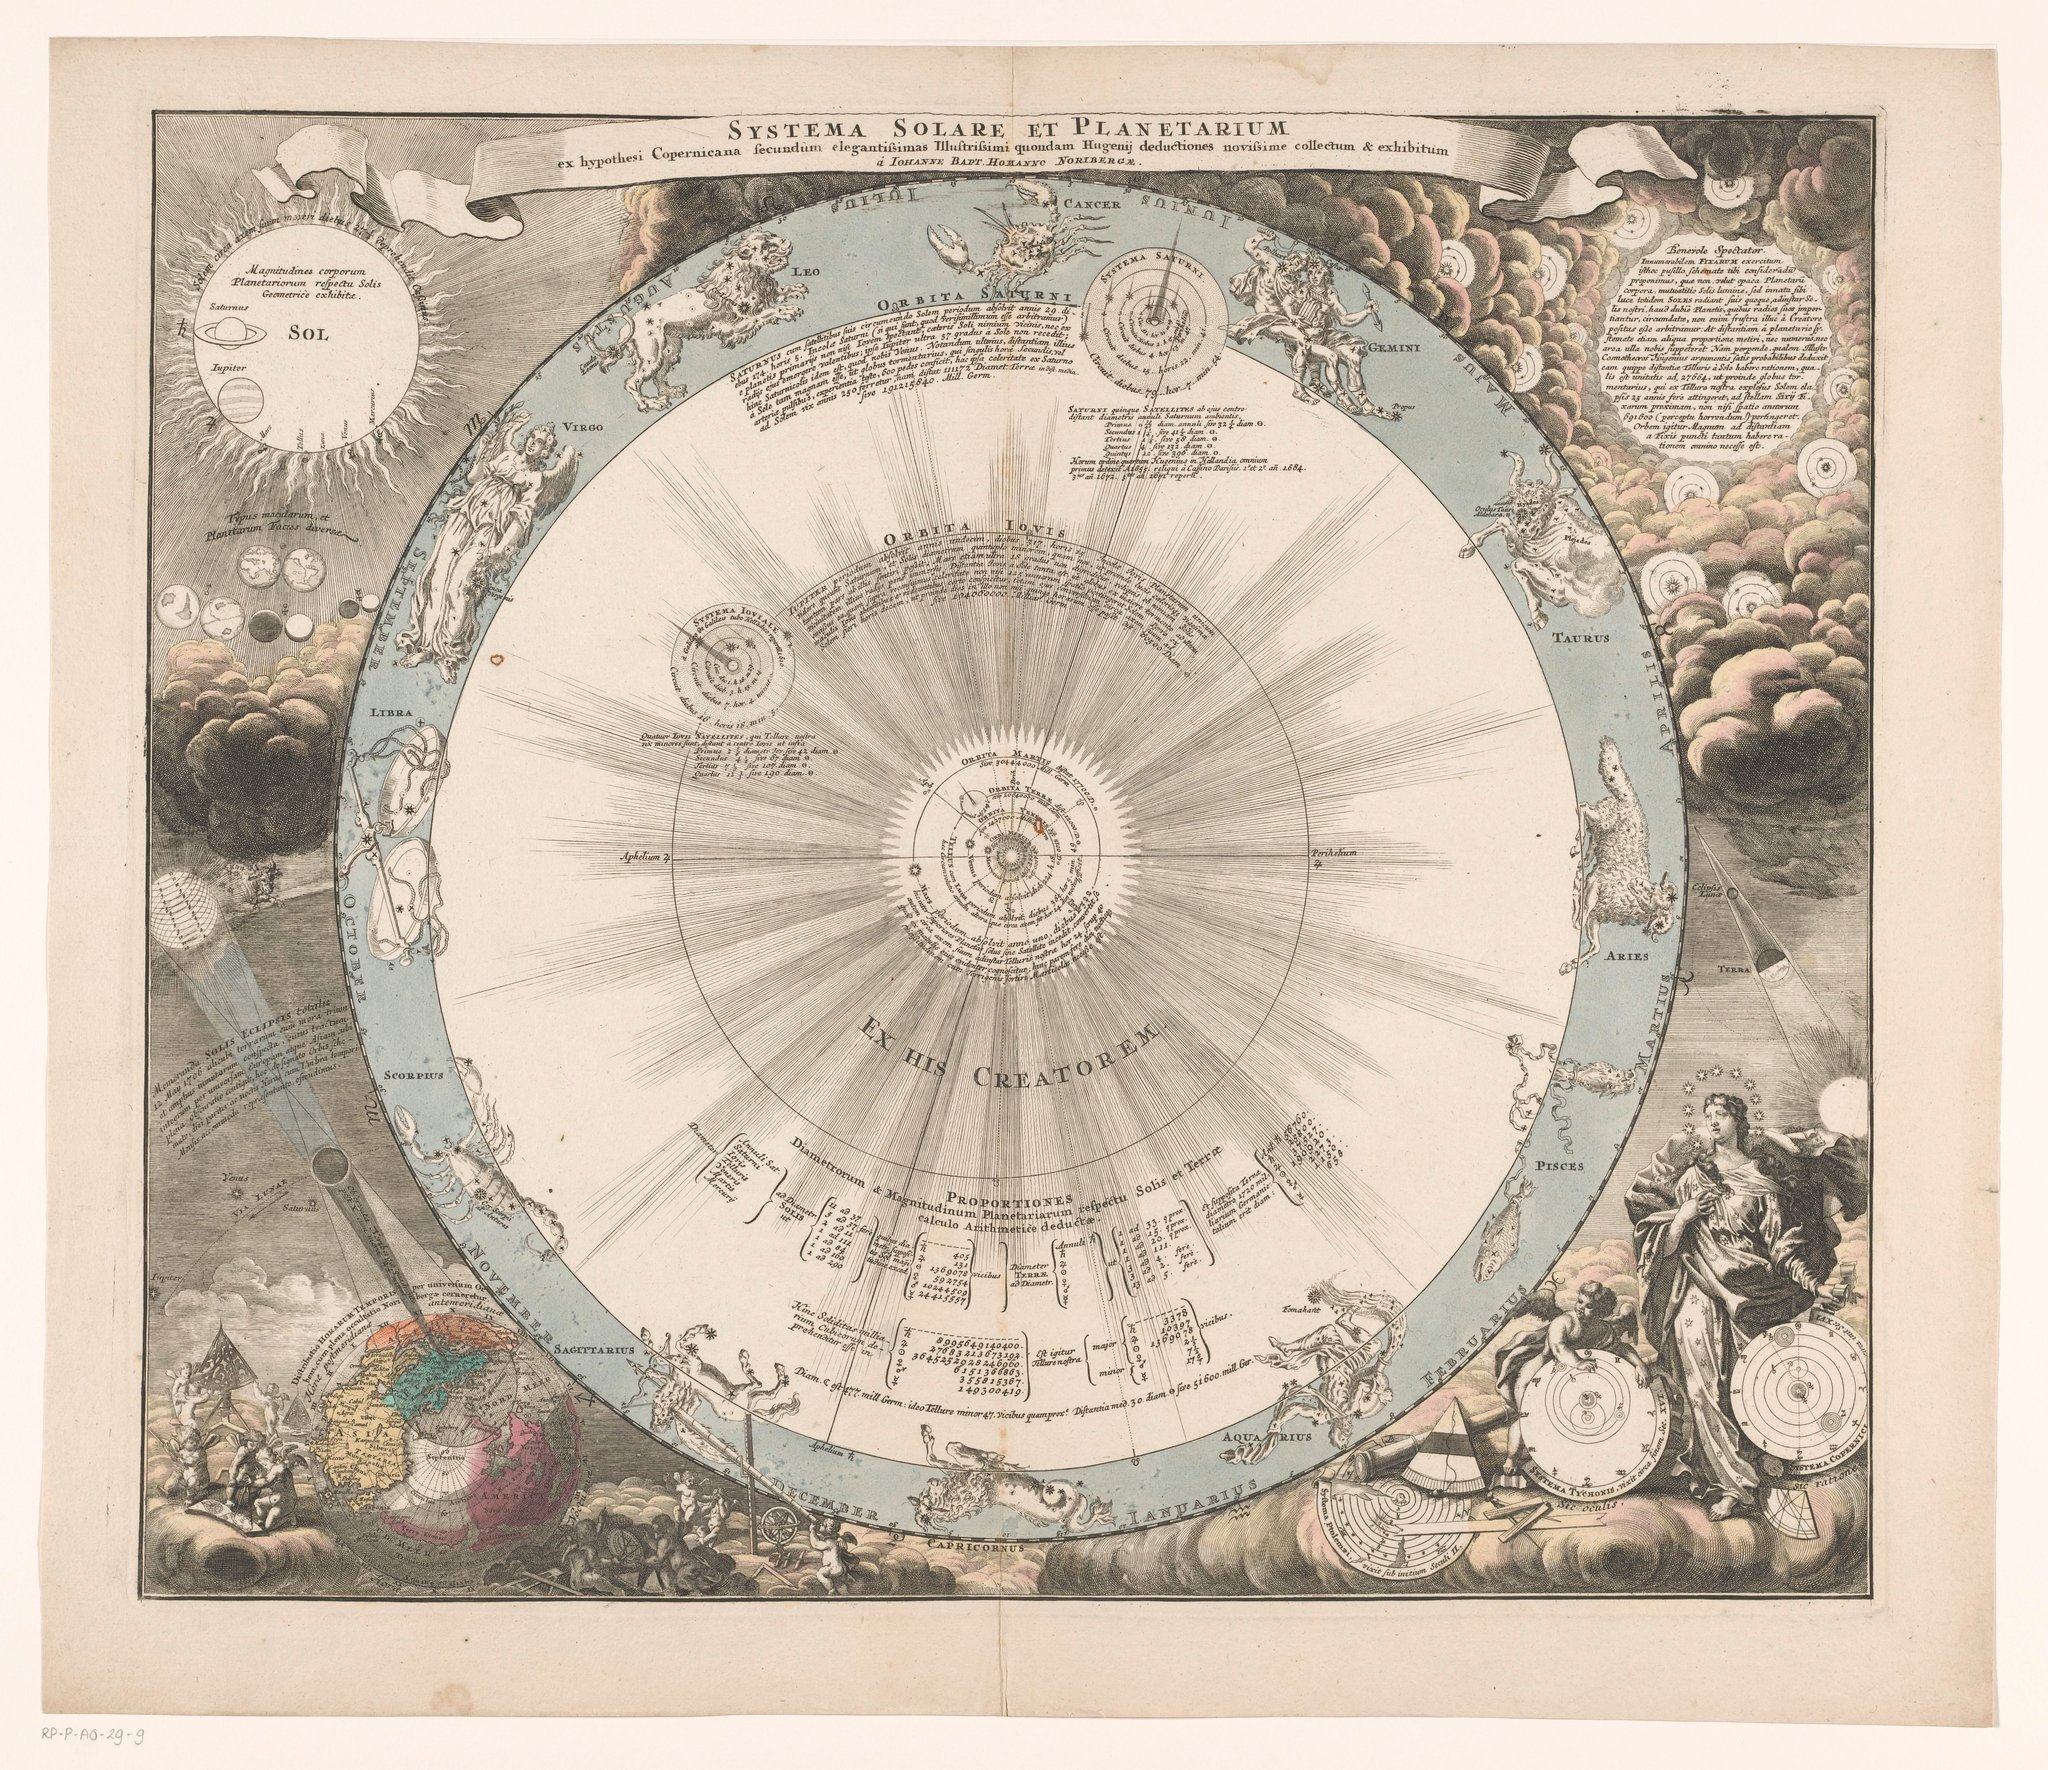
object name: print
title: Systema solare et planetarium ex hypothesi Copernicana secundum (...)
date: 1702-1742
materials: paper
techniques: engraving, etching, hand coloring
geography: nuremberg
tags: earth, world as celestial body, telescope, solar eclipse, planets; planetary system, solar system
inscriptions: collector's mark: Lugt 2228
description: Hemelkaart van het heliocentrische stelsel van Nicolaas Copernicus. In de buitenste ring de dierenriem. De titel in een banderol boven de kaart. Rechtsonder een voorstelling van Urania bij weergaven van de stelsels van Ptolemaeus, Copernicus en Brahe. Linksonder een voorstelling waar wordt uitgelegd hoe een zonsverduistering tot stand komt. Om de voorstelling heen putti met astronomische en meetkundige instrumenten. Linksboven de Zon, Jupiter en Saturnus, ter vergelijking van de relatieve grootte.